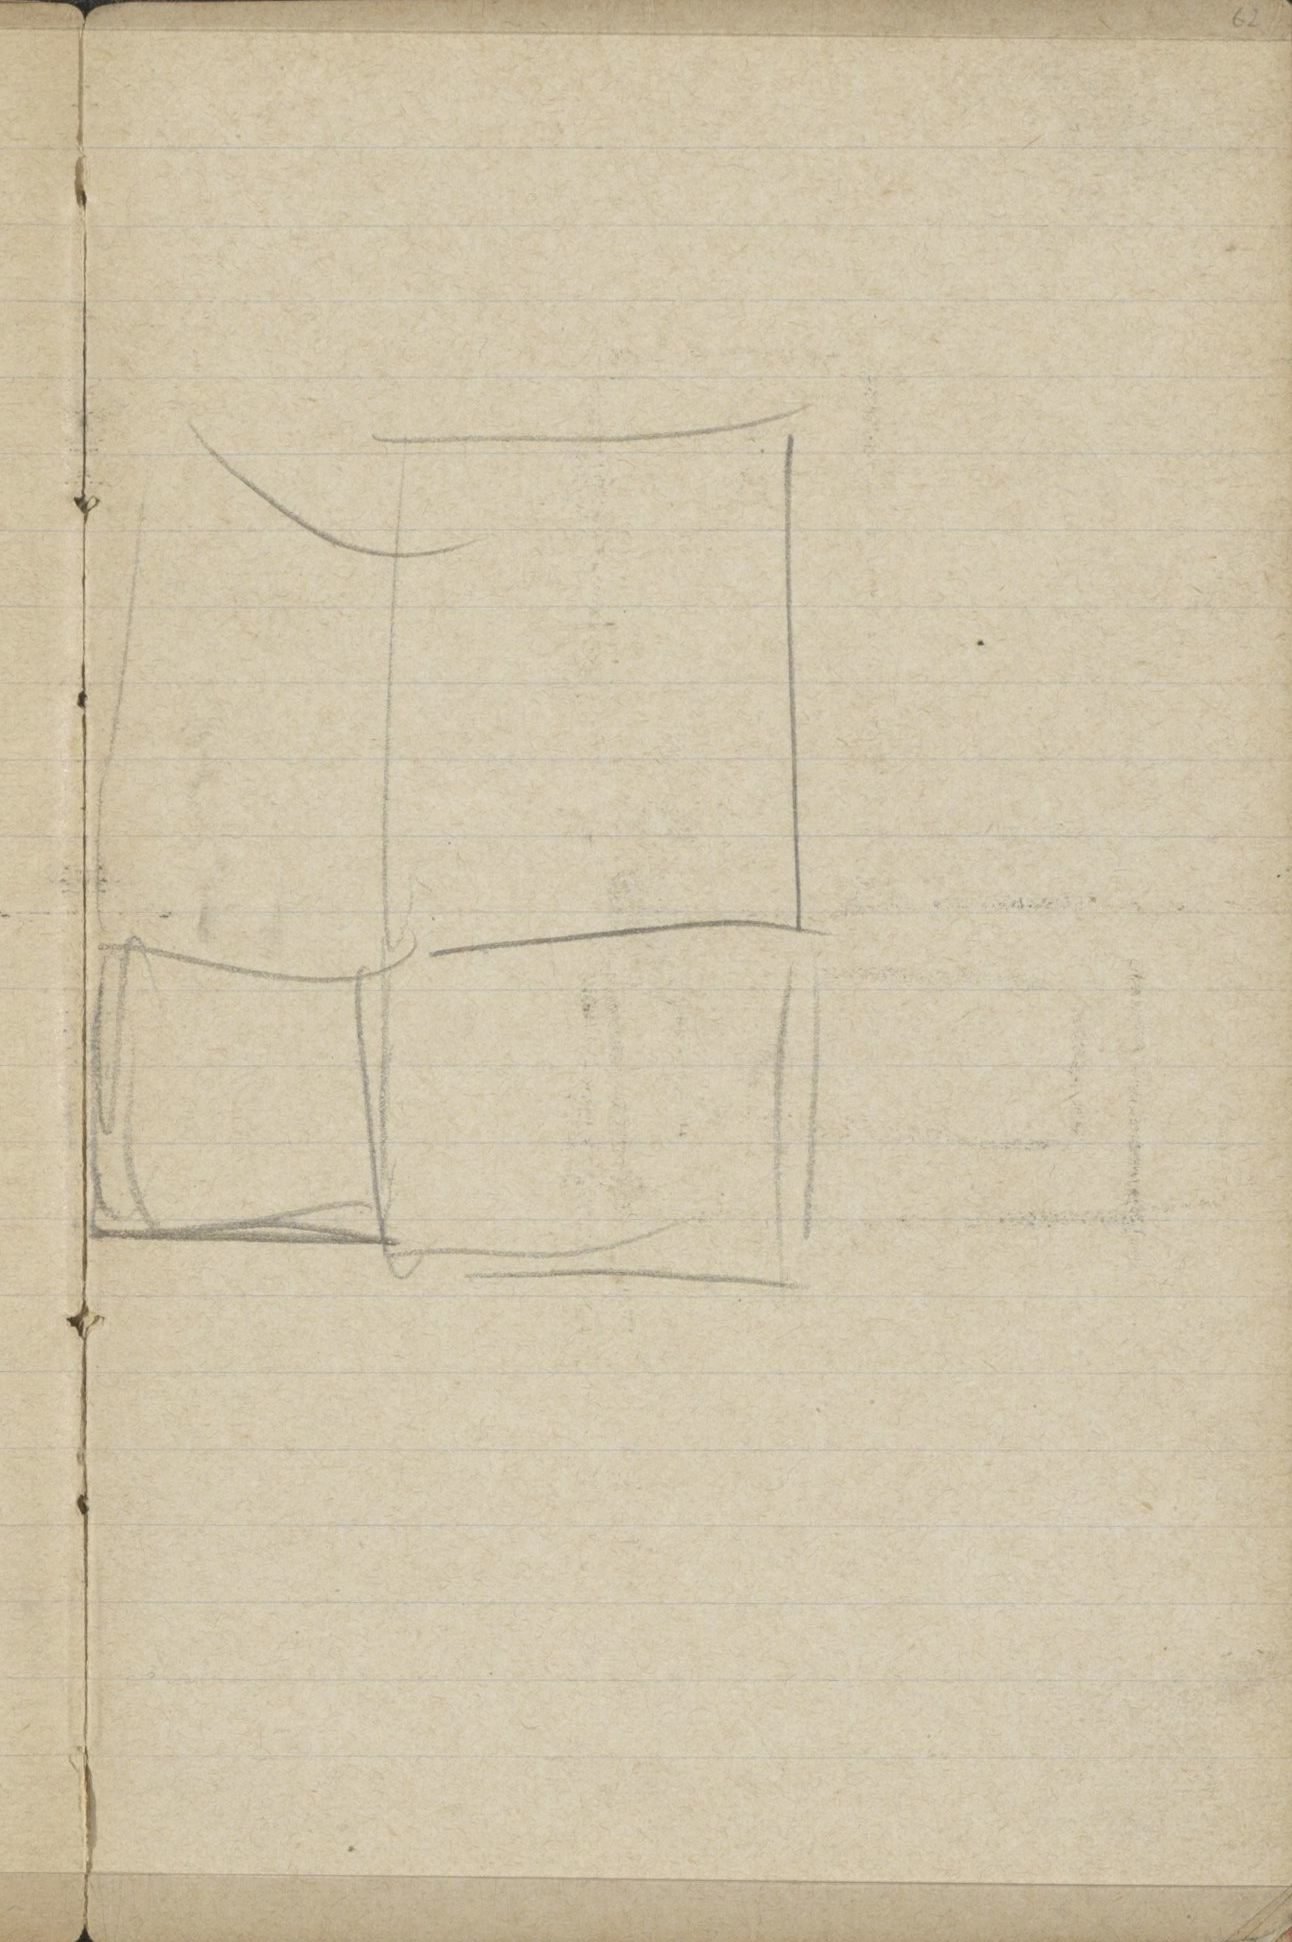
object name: sketchbook leaf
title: Studie, mogelijk van een gevel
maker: george hendrik breitner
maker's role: draughtsman, painter, print maker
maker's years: 1857-1923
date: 1886-1903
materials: pencil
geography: amsterdam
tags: façade (of house or building), civic architecture; edifices; dwellings, amsterdam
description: Pagina 62 uit een schetsboek met 41 bladen.